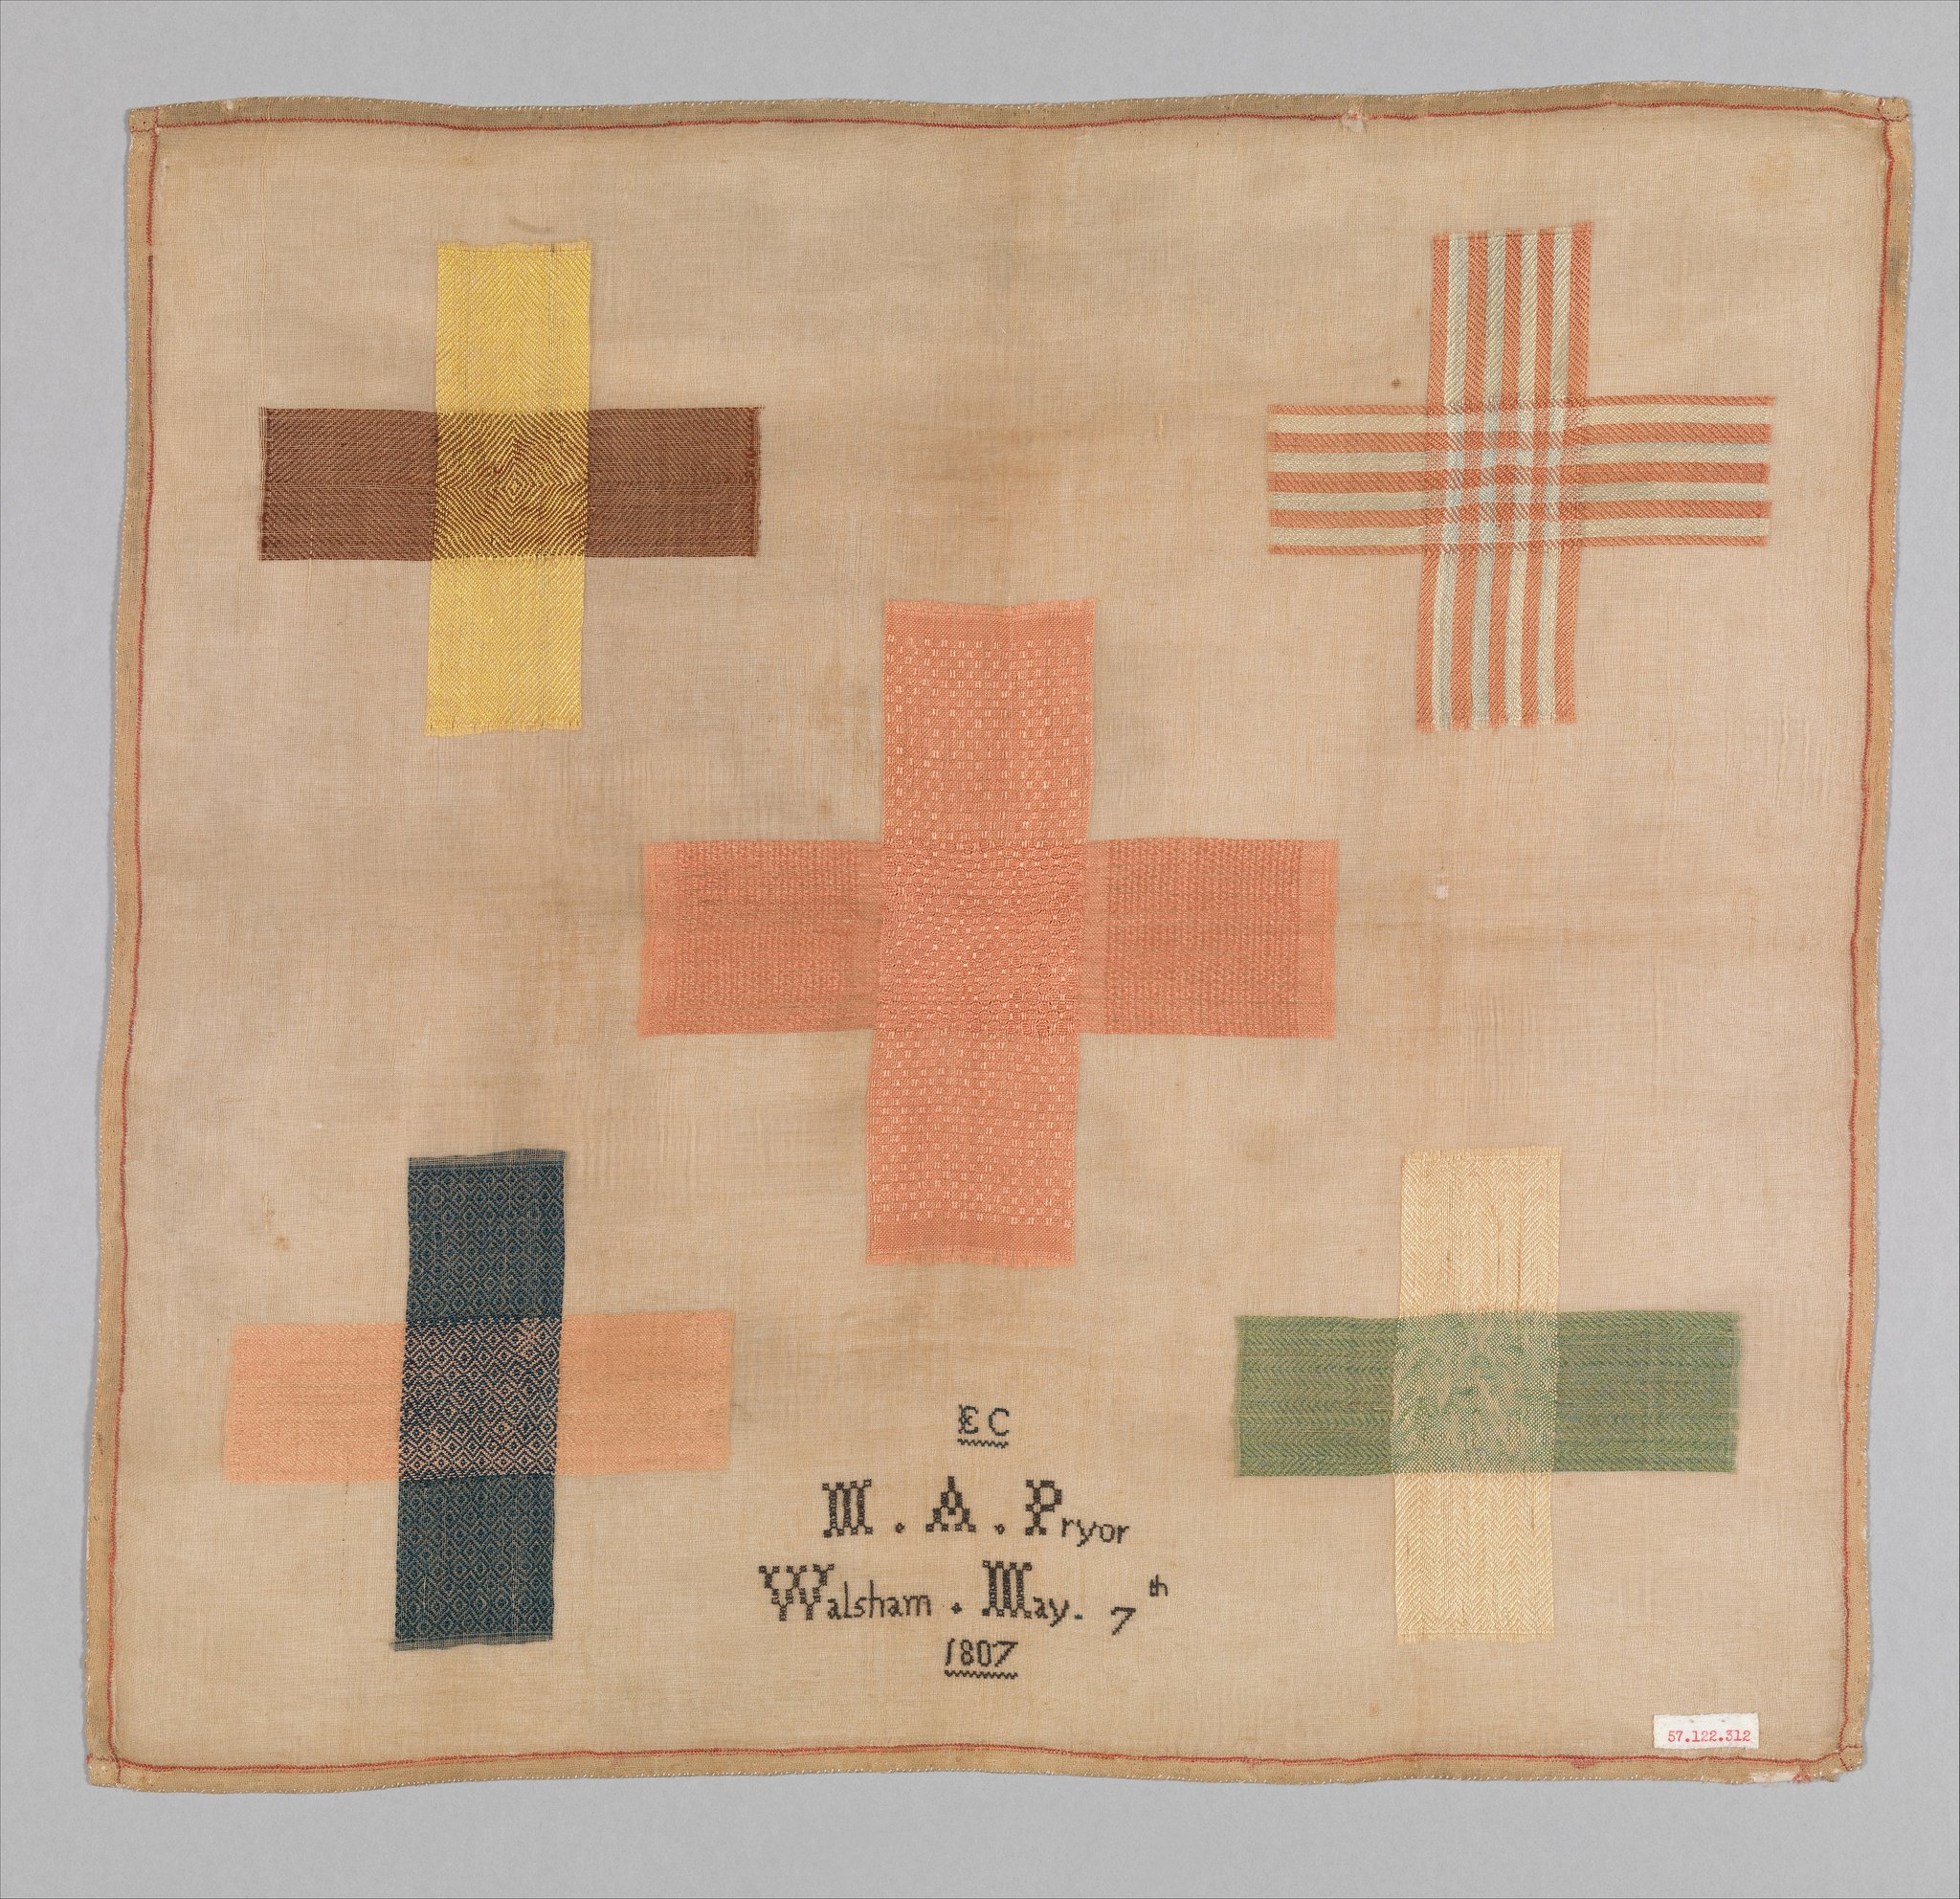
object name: sampler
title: Embroidered darning sampler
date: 1807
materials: linen, silk